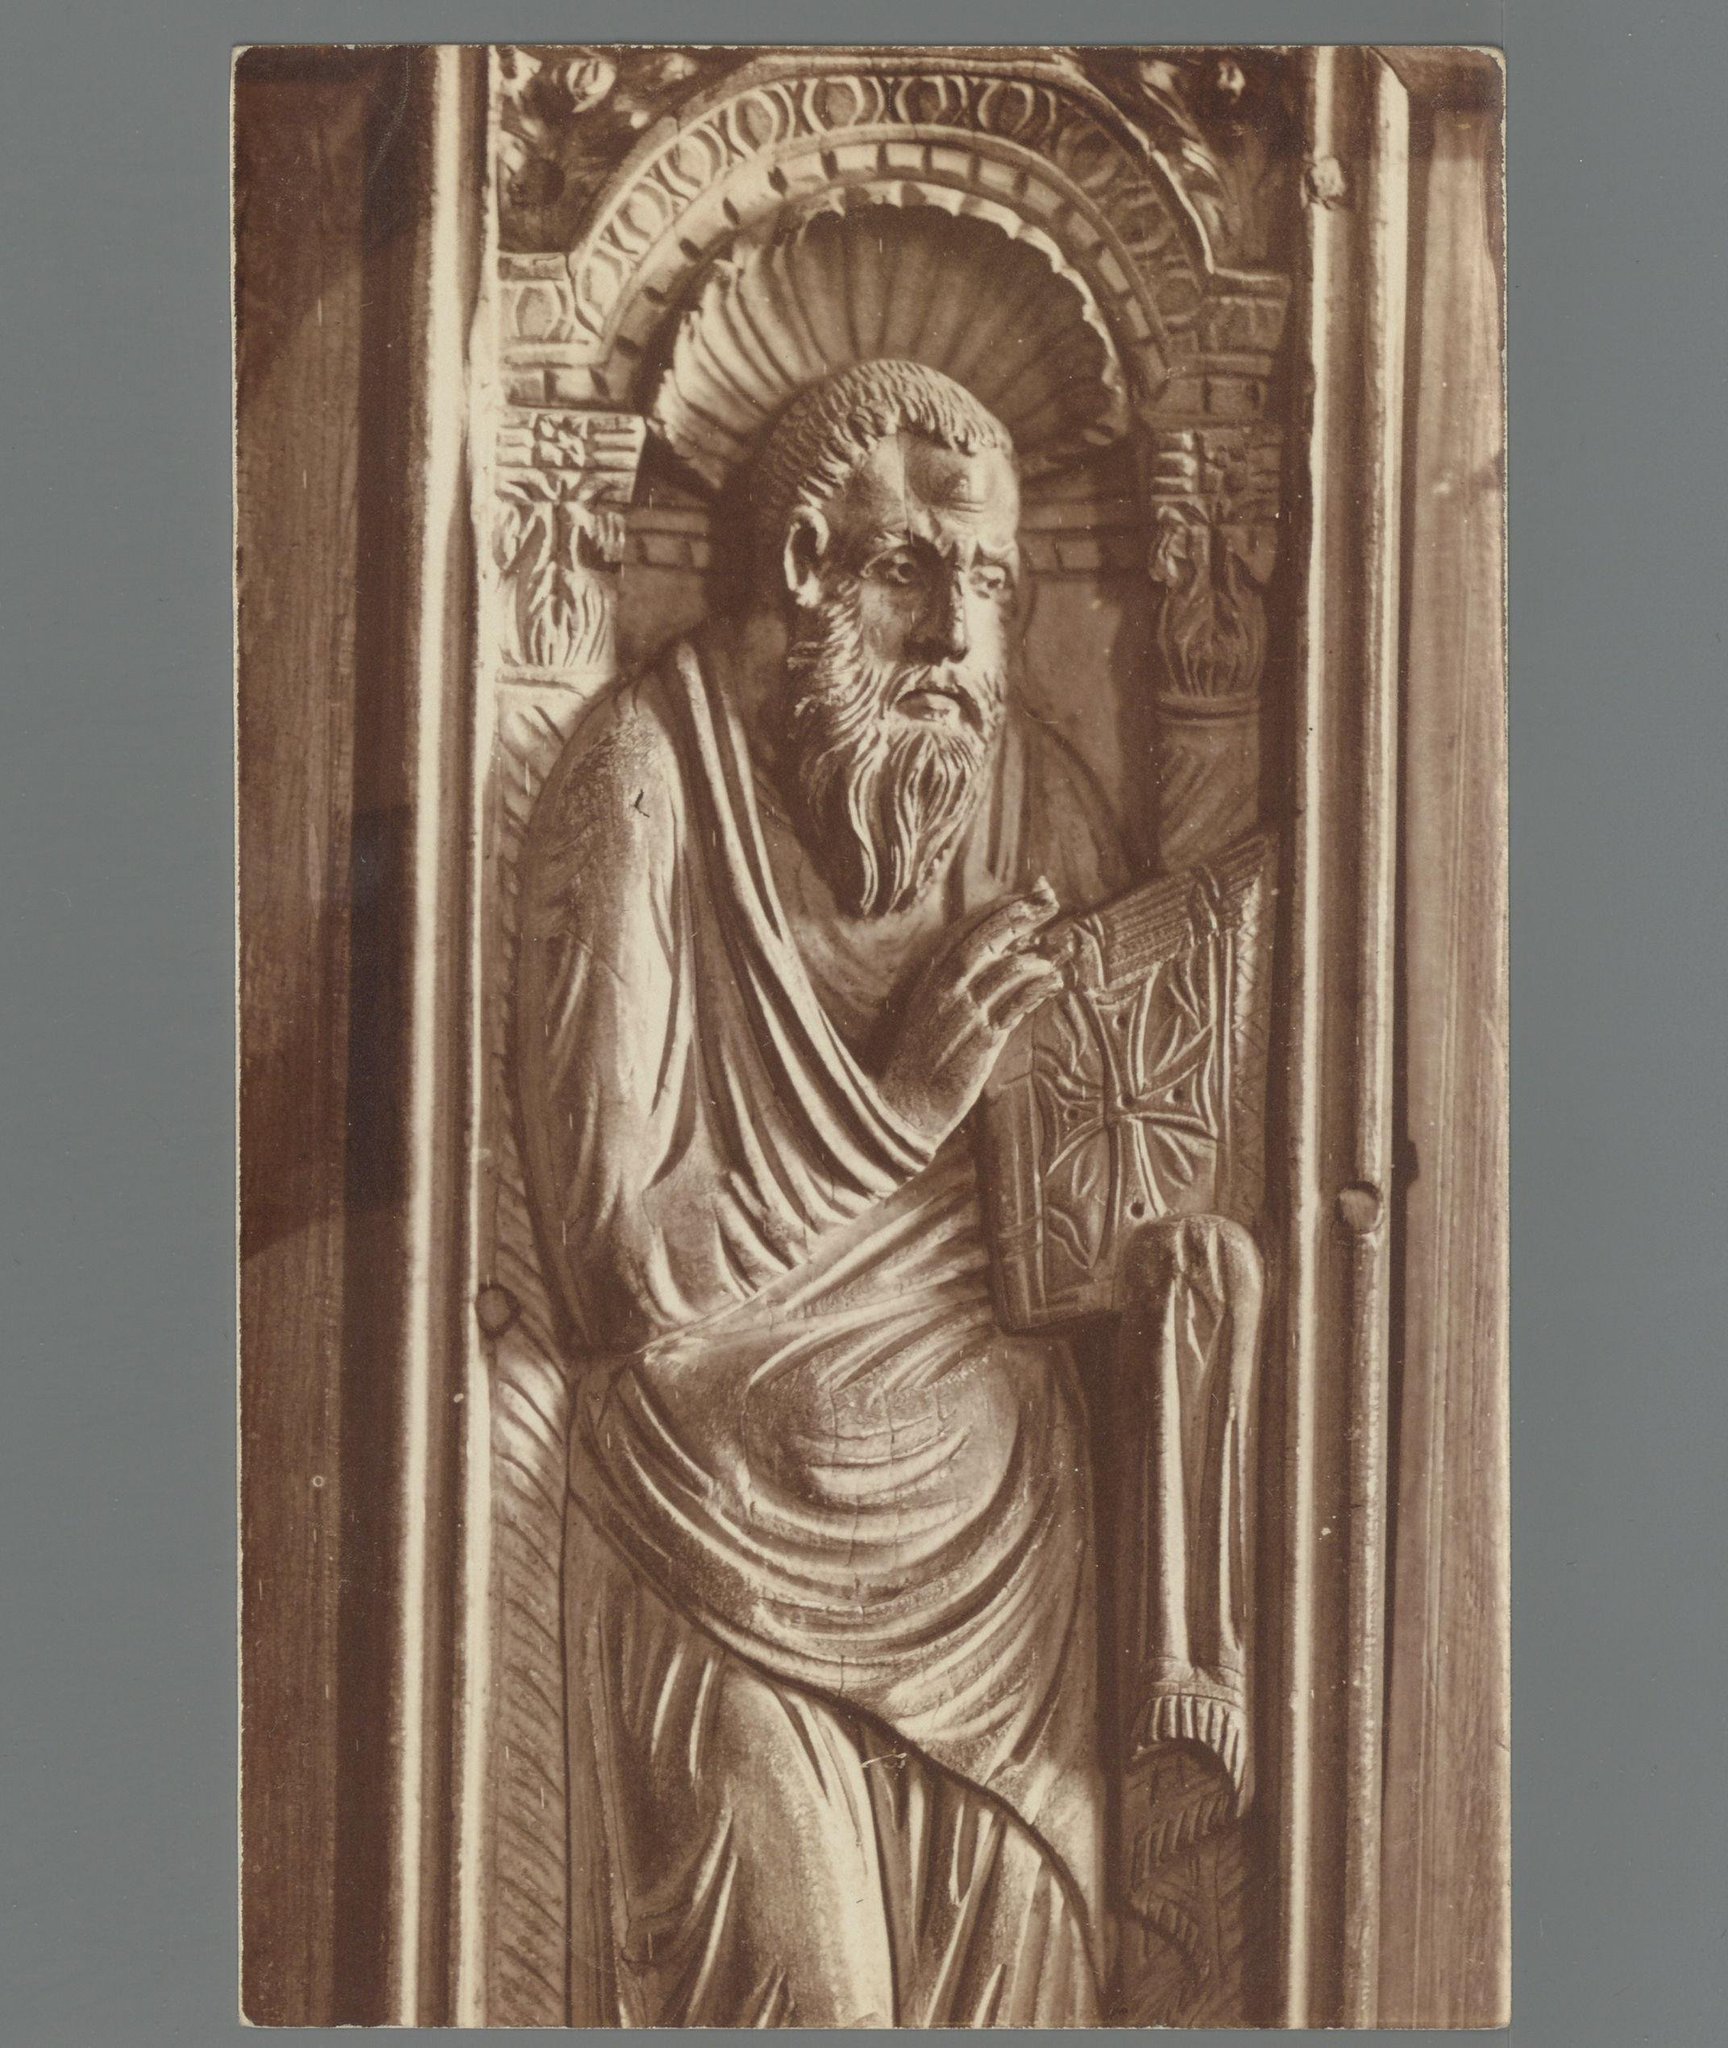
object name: photograph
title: Haut-reliëf van een evangelist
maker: l. ricci (fotograaf)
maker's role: fotograaf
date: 1906-1920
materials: photographic support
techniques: photography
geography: ravenna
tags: saints, sculpture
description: Het haut-reliëf is onderdeel van de troon van aartsbisschop Maximianus in de Basilica di San Vitale in Ravenna.